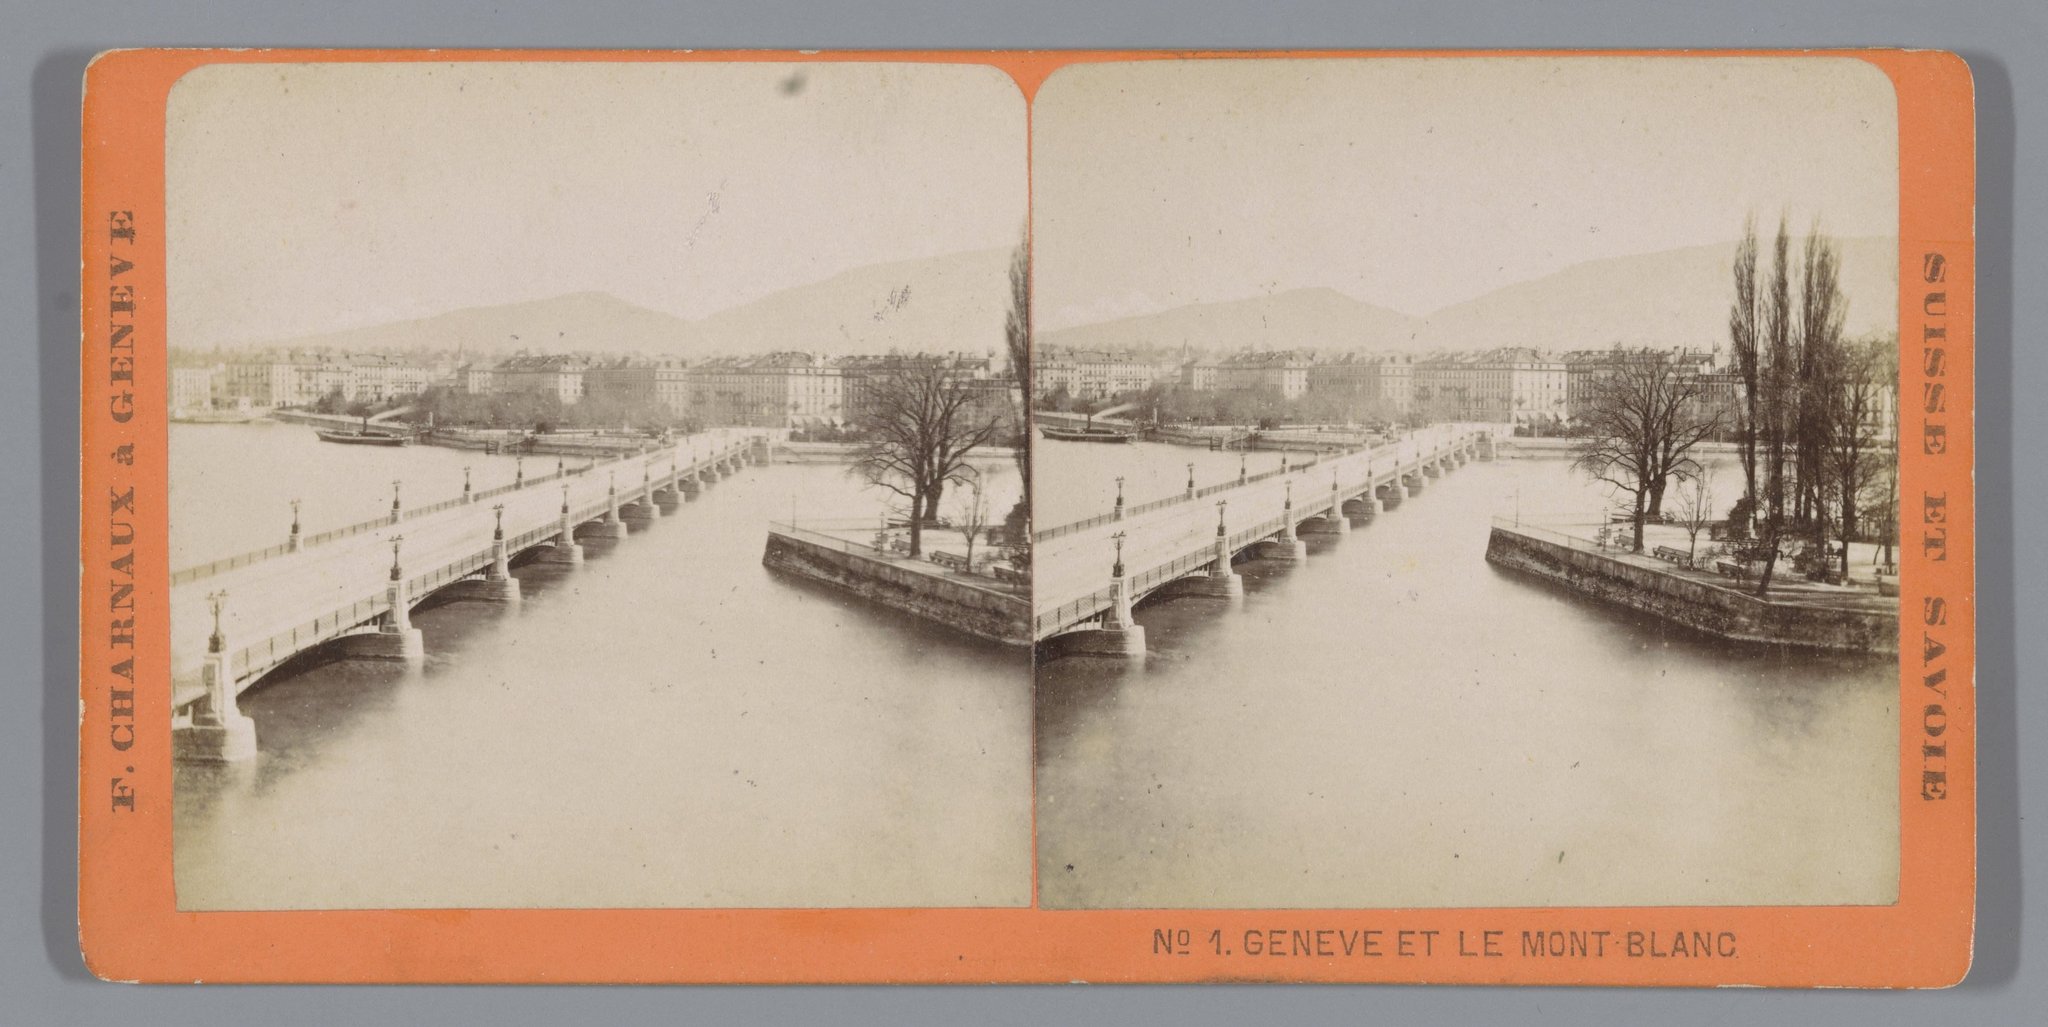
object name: stereograph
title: Gezicht op Genève, met op de voorgrond de Pont du Mont-Blanc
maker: florentin charnaux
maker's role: publisher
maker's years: 1819-1883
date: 1879-1885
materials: cardboard, photographic support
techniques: albumen print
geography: geneva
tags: city-view in general; 'veduta', bridge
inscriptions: inscription: ‘No 1.’, inscription: ‘Suisse et Savoie’, annotation: ‘Paris 1870 Lyon 1872 Vienne 1873 Philadelphia 1876 Paris 1878 Paris 1879 Maison des Trois Rois - F. Charnaux Genève.’